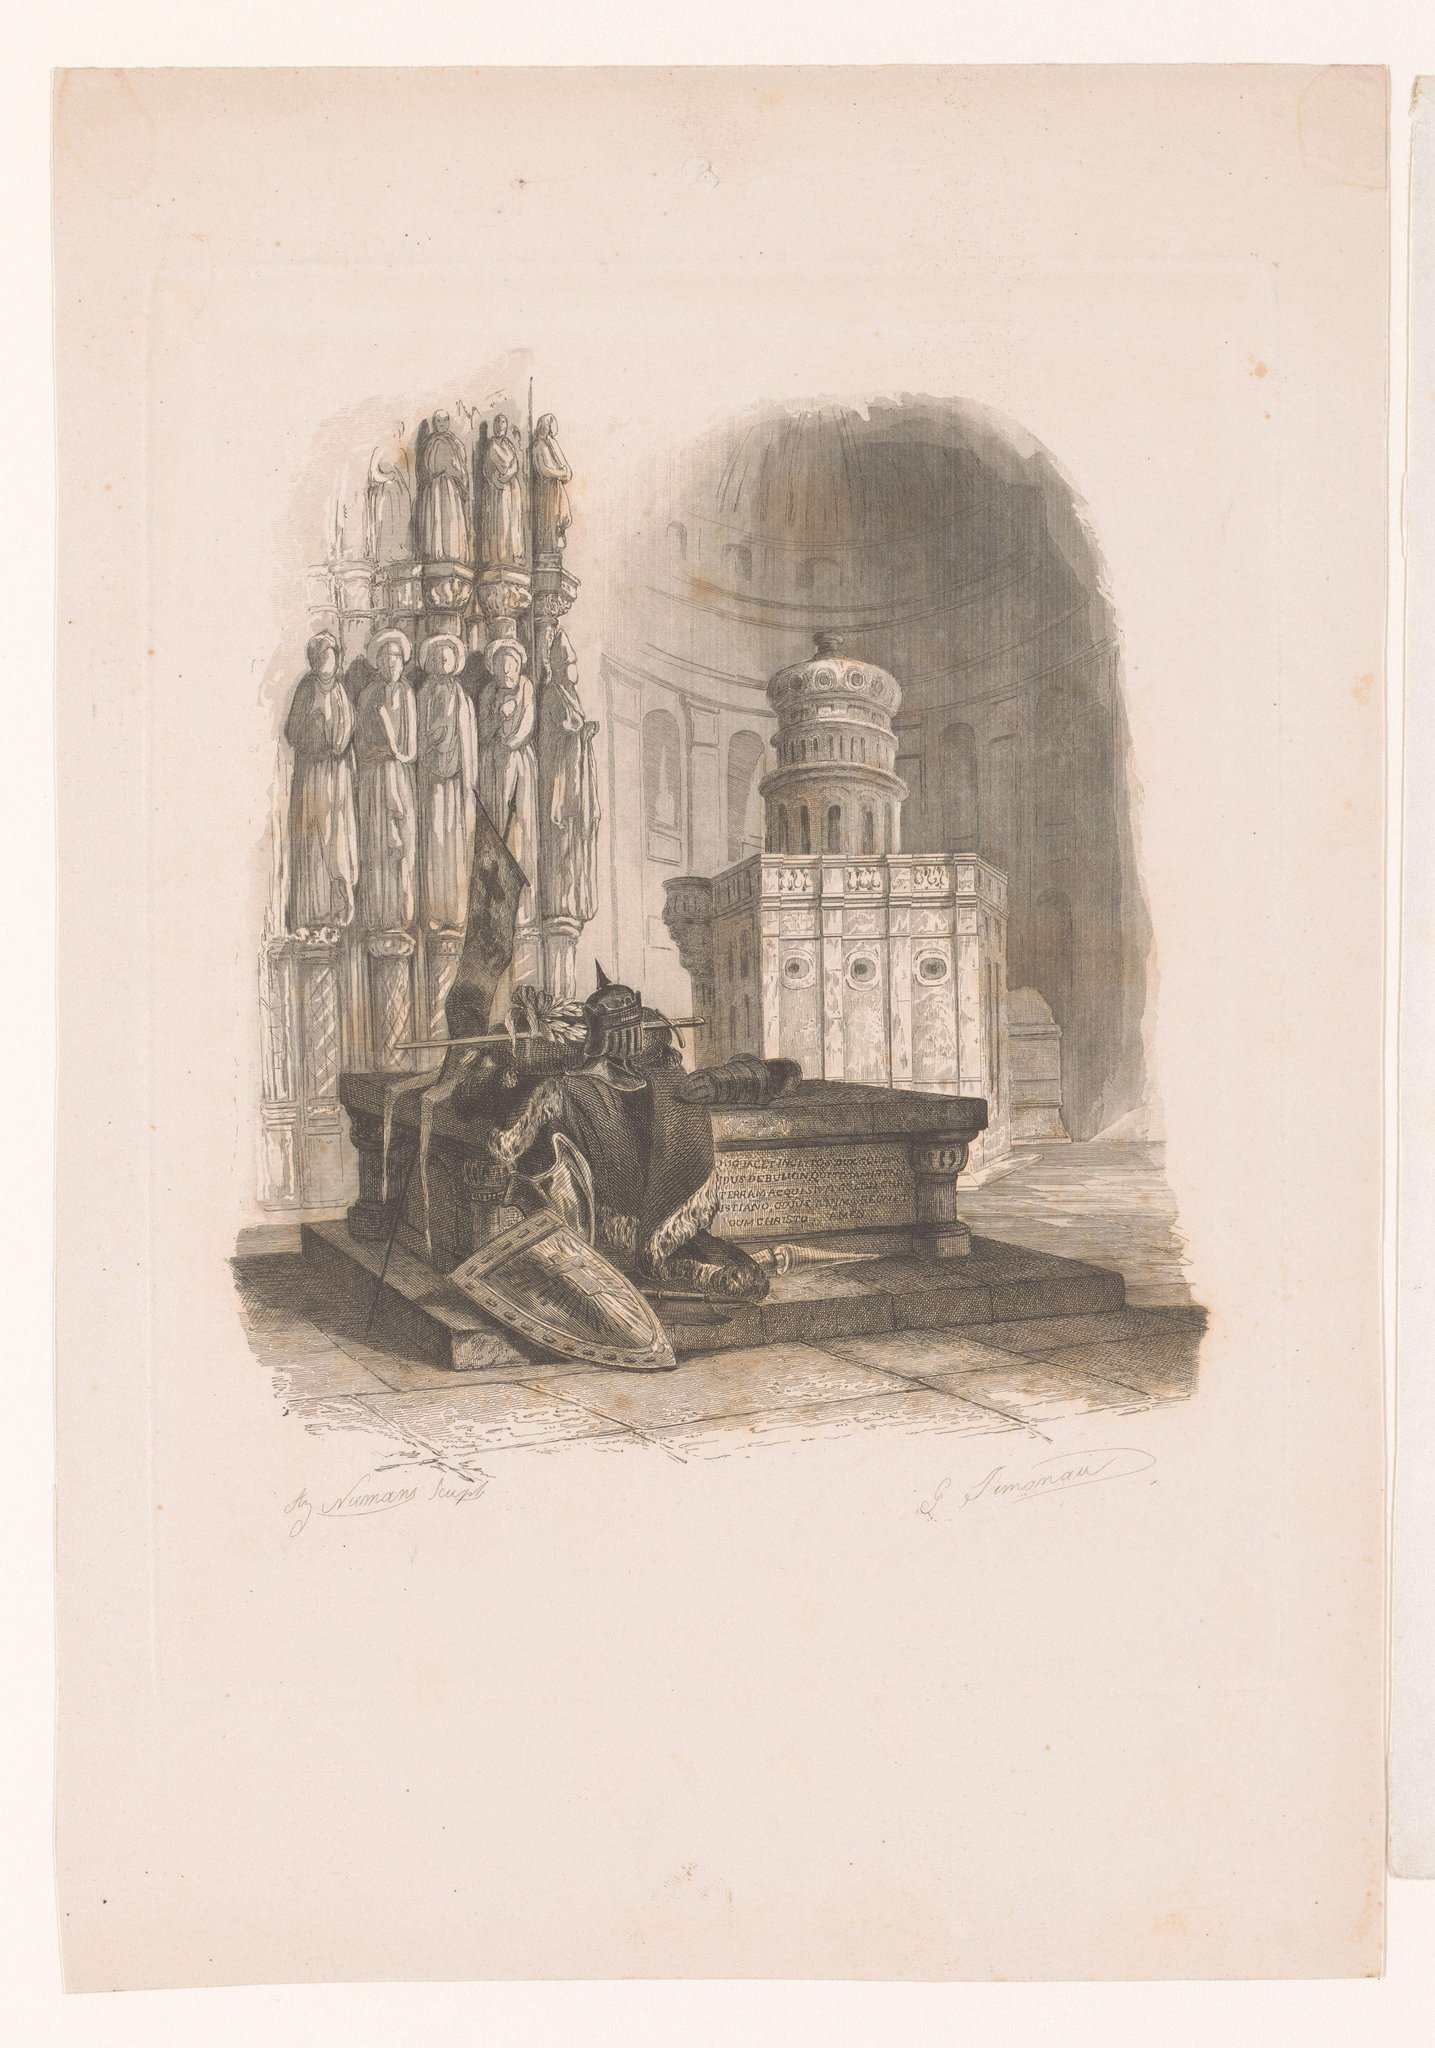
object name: print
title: Graftombe van Godfried van Bouillon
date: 1833-1879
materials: paper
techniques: etching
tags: godfrey of bouillon, armour, grave, tomb, interior of church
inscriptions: collector's mark: Lugt 2228